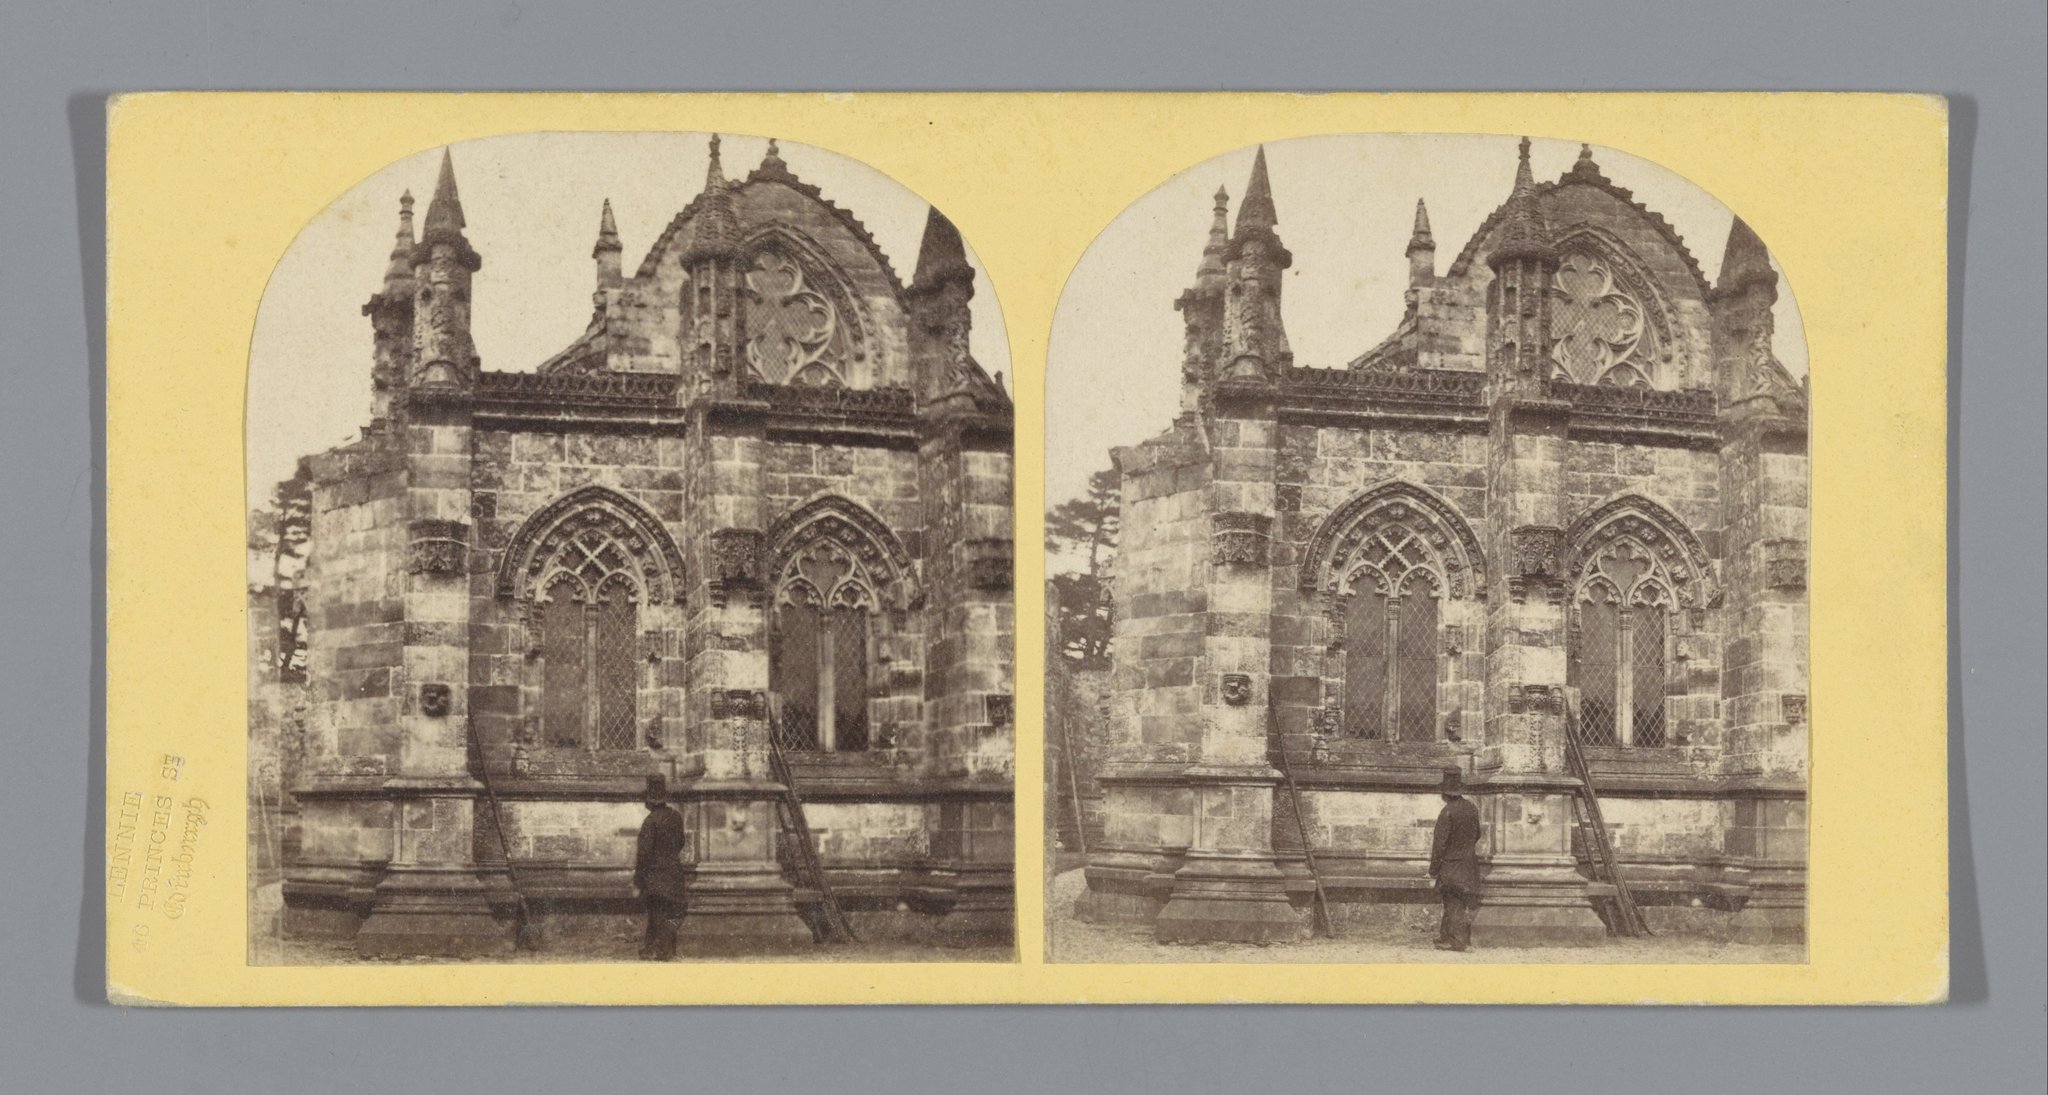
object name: stereograph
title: Roslin Chapel.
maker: Anonymous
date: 1850-1880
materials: cardboard, photographic support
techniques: albumen print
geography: roslin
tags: church (exterior), façade (of house or building)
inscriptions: inscription: ‘Realities of the Waverley Novels, Burns' Poems, Scottish Songs, &c.’, name: ‘Lennie 46 Princes Str Edinburgh’, number: ‘No. 4.’, inscription: ‘This beautiful specimen of the florid Gothic ecclesiastical architecture (...) Lay of the Last Minstrel.’